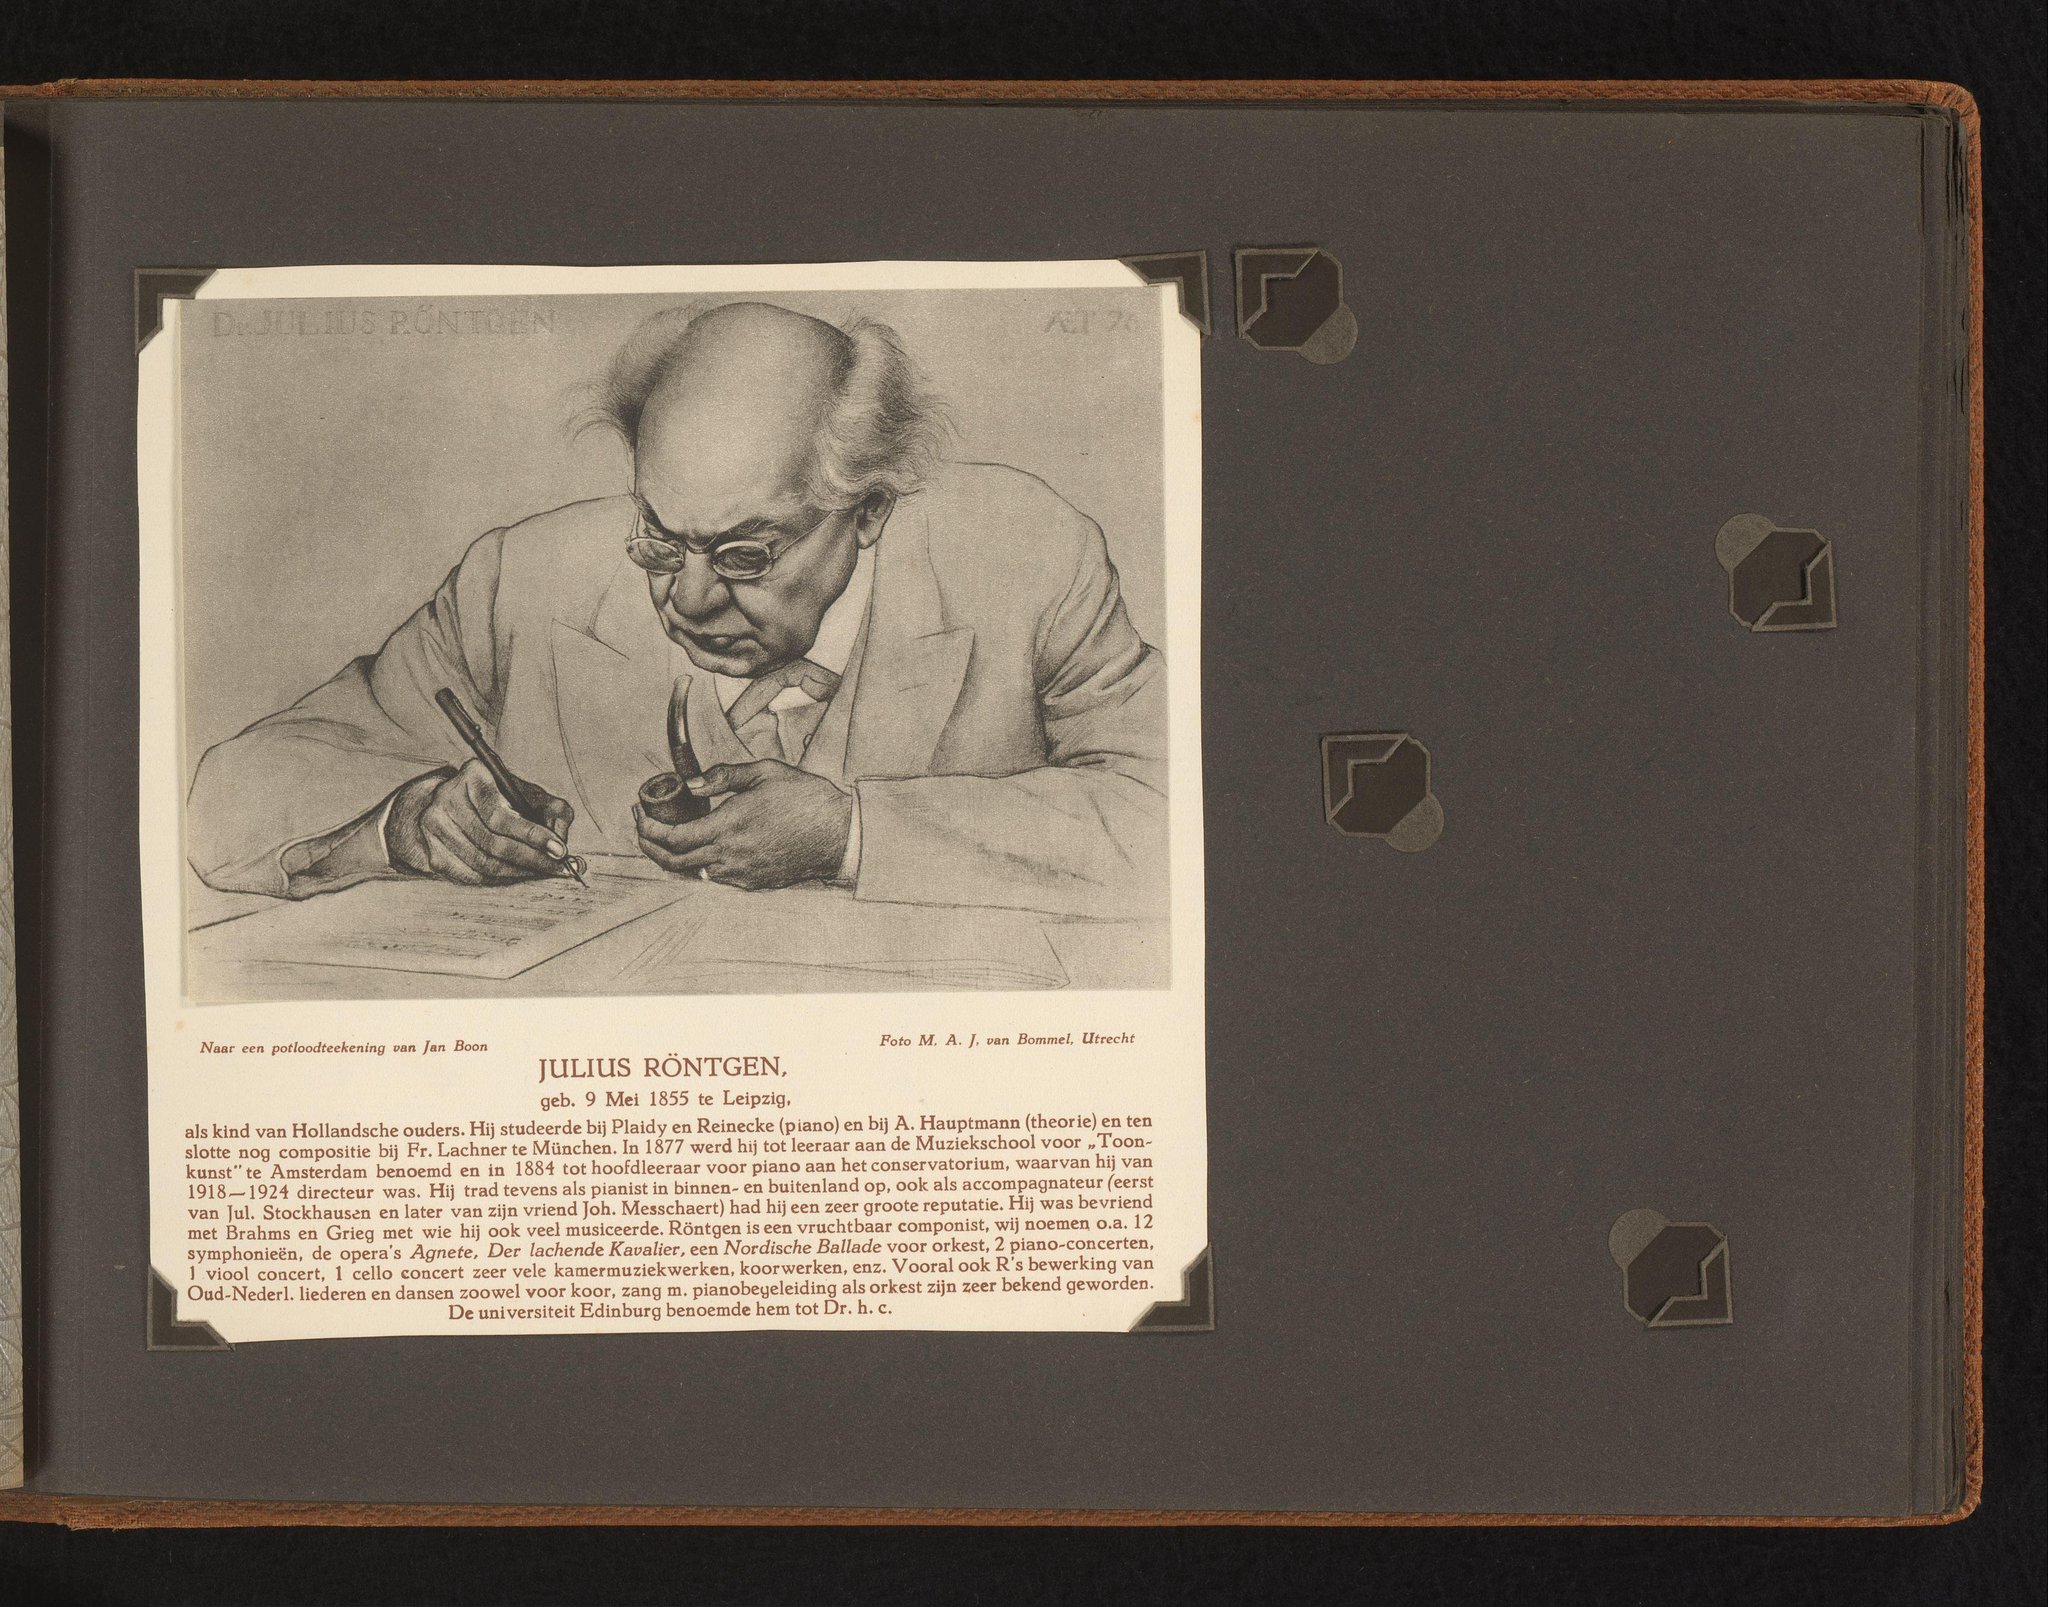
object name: album leaf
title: Julius Röntgen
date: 1933-1936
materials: paper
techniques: rotogravure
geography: utrecht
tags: julius röntgen, portrait of composer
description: Albumblad met een portret van de componist Julius Röntgen, met tekst. Onderdeel van het Esperanto album uit ca. 1933-1936.